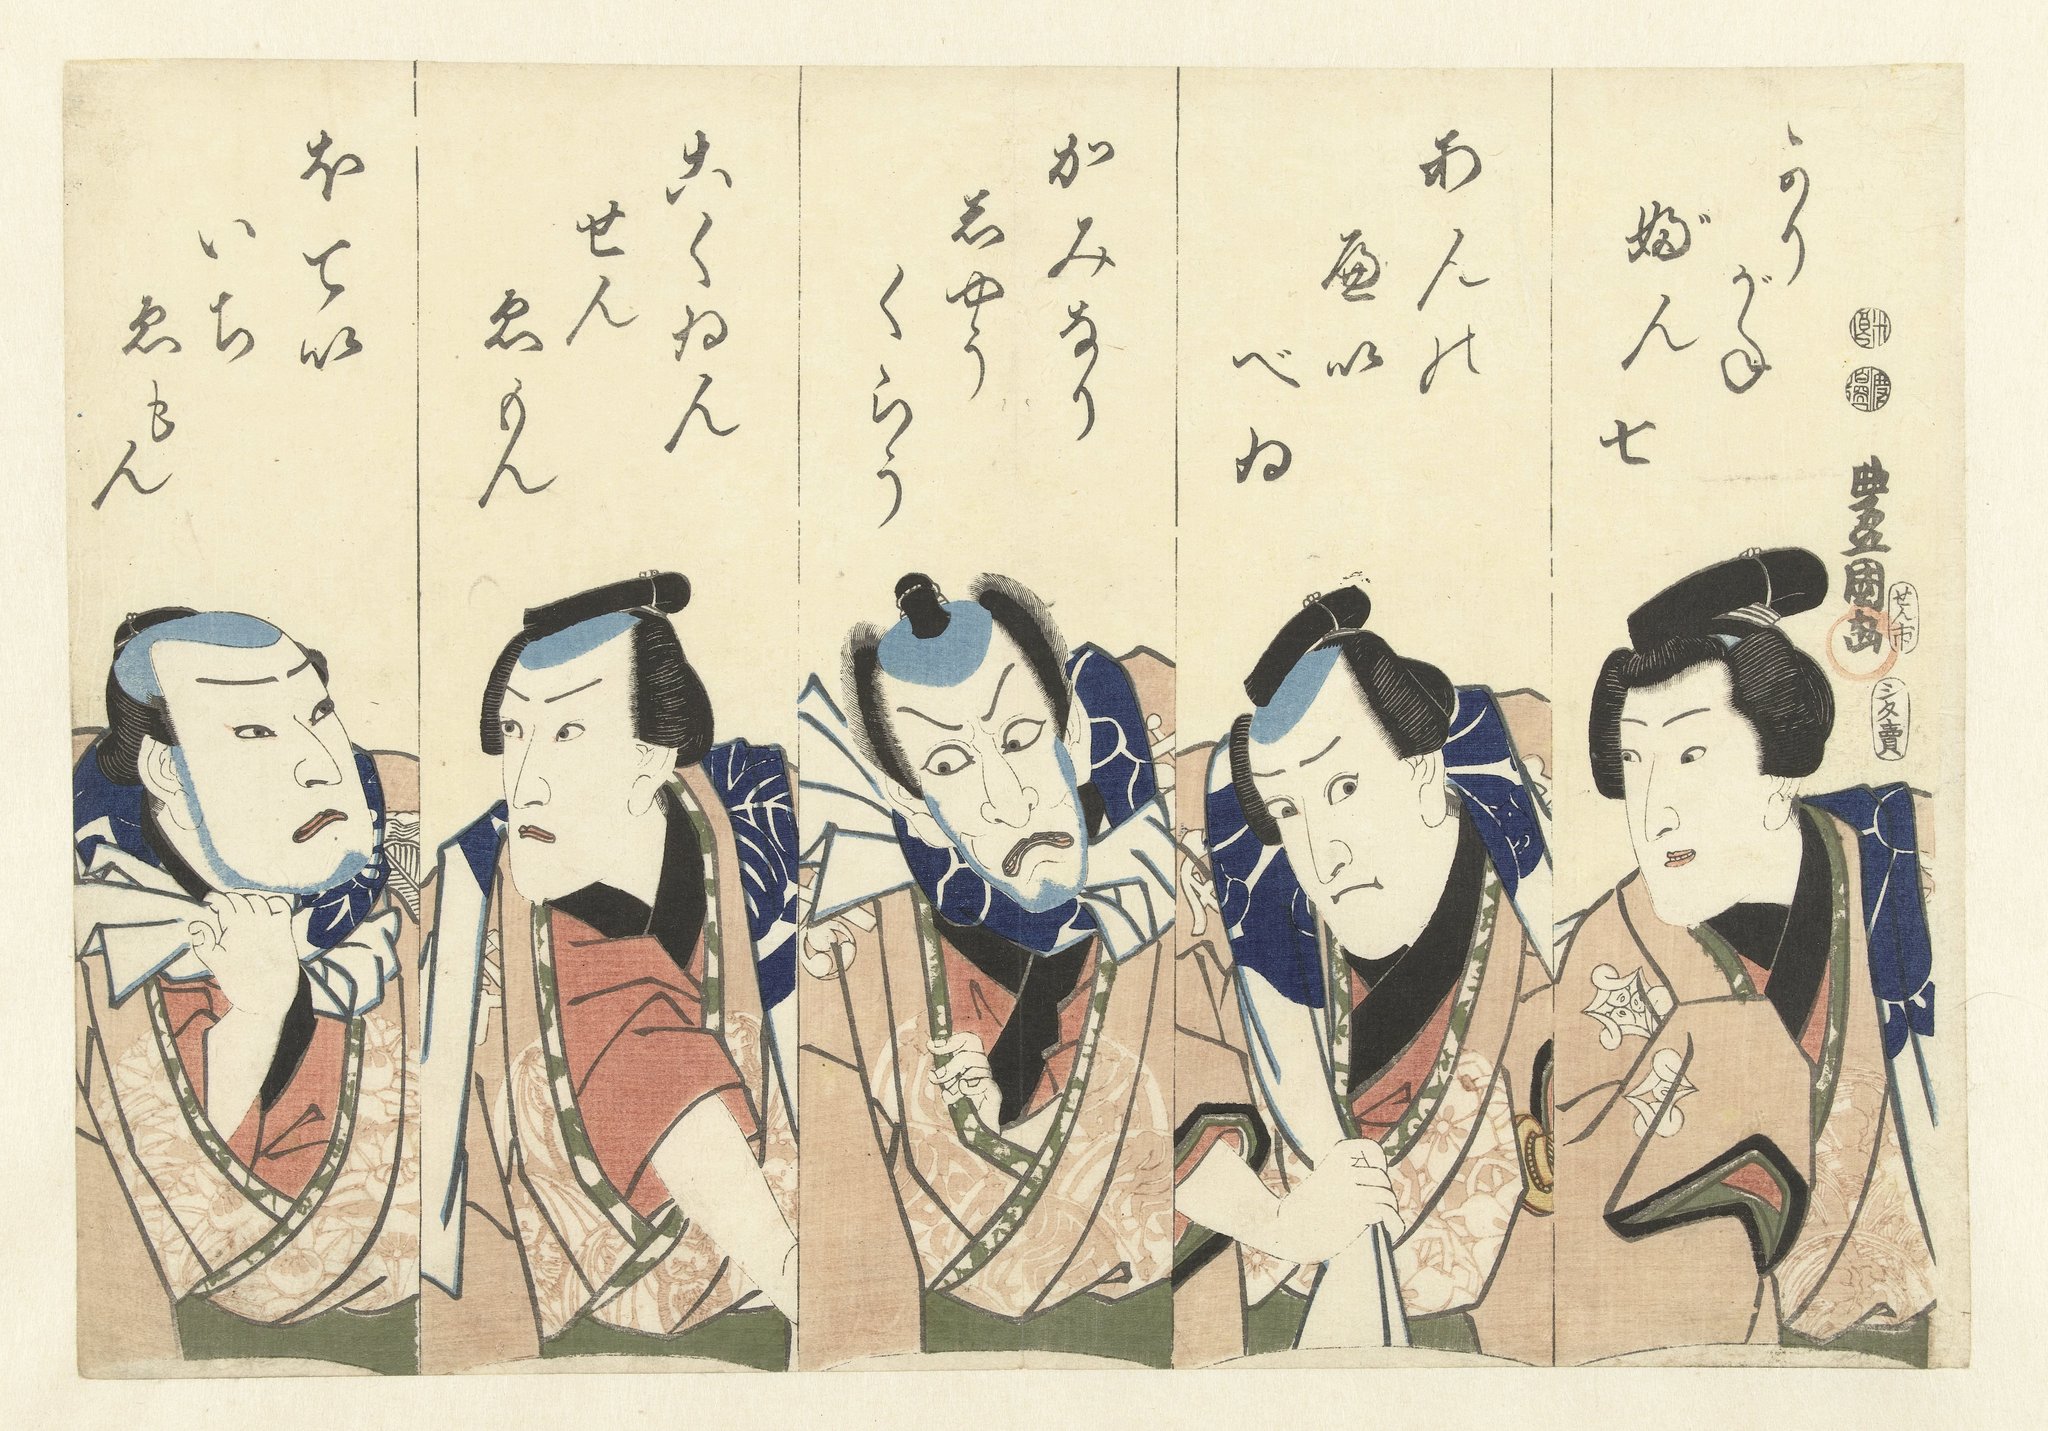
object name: print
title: Acteurs uit het toneelstuk Gonin Otoko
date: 1851-1853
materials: paper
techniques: woodcut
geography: japan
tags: adult man (+ five persons), portrait of actor, actress, japan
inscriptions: collector's mark: Lugt 2760, collector's mark: Lugt 2228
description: Vijf acteurs in het toneelstuk Gonin Otoko; naast elkaar ten halven lijve afgebeeld.